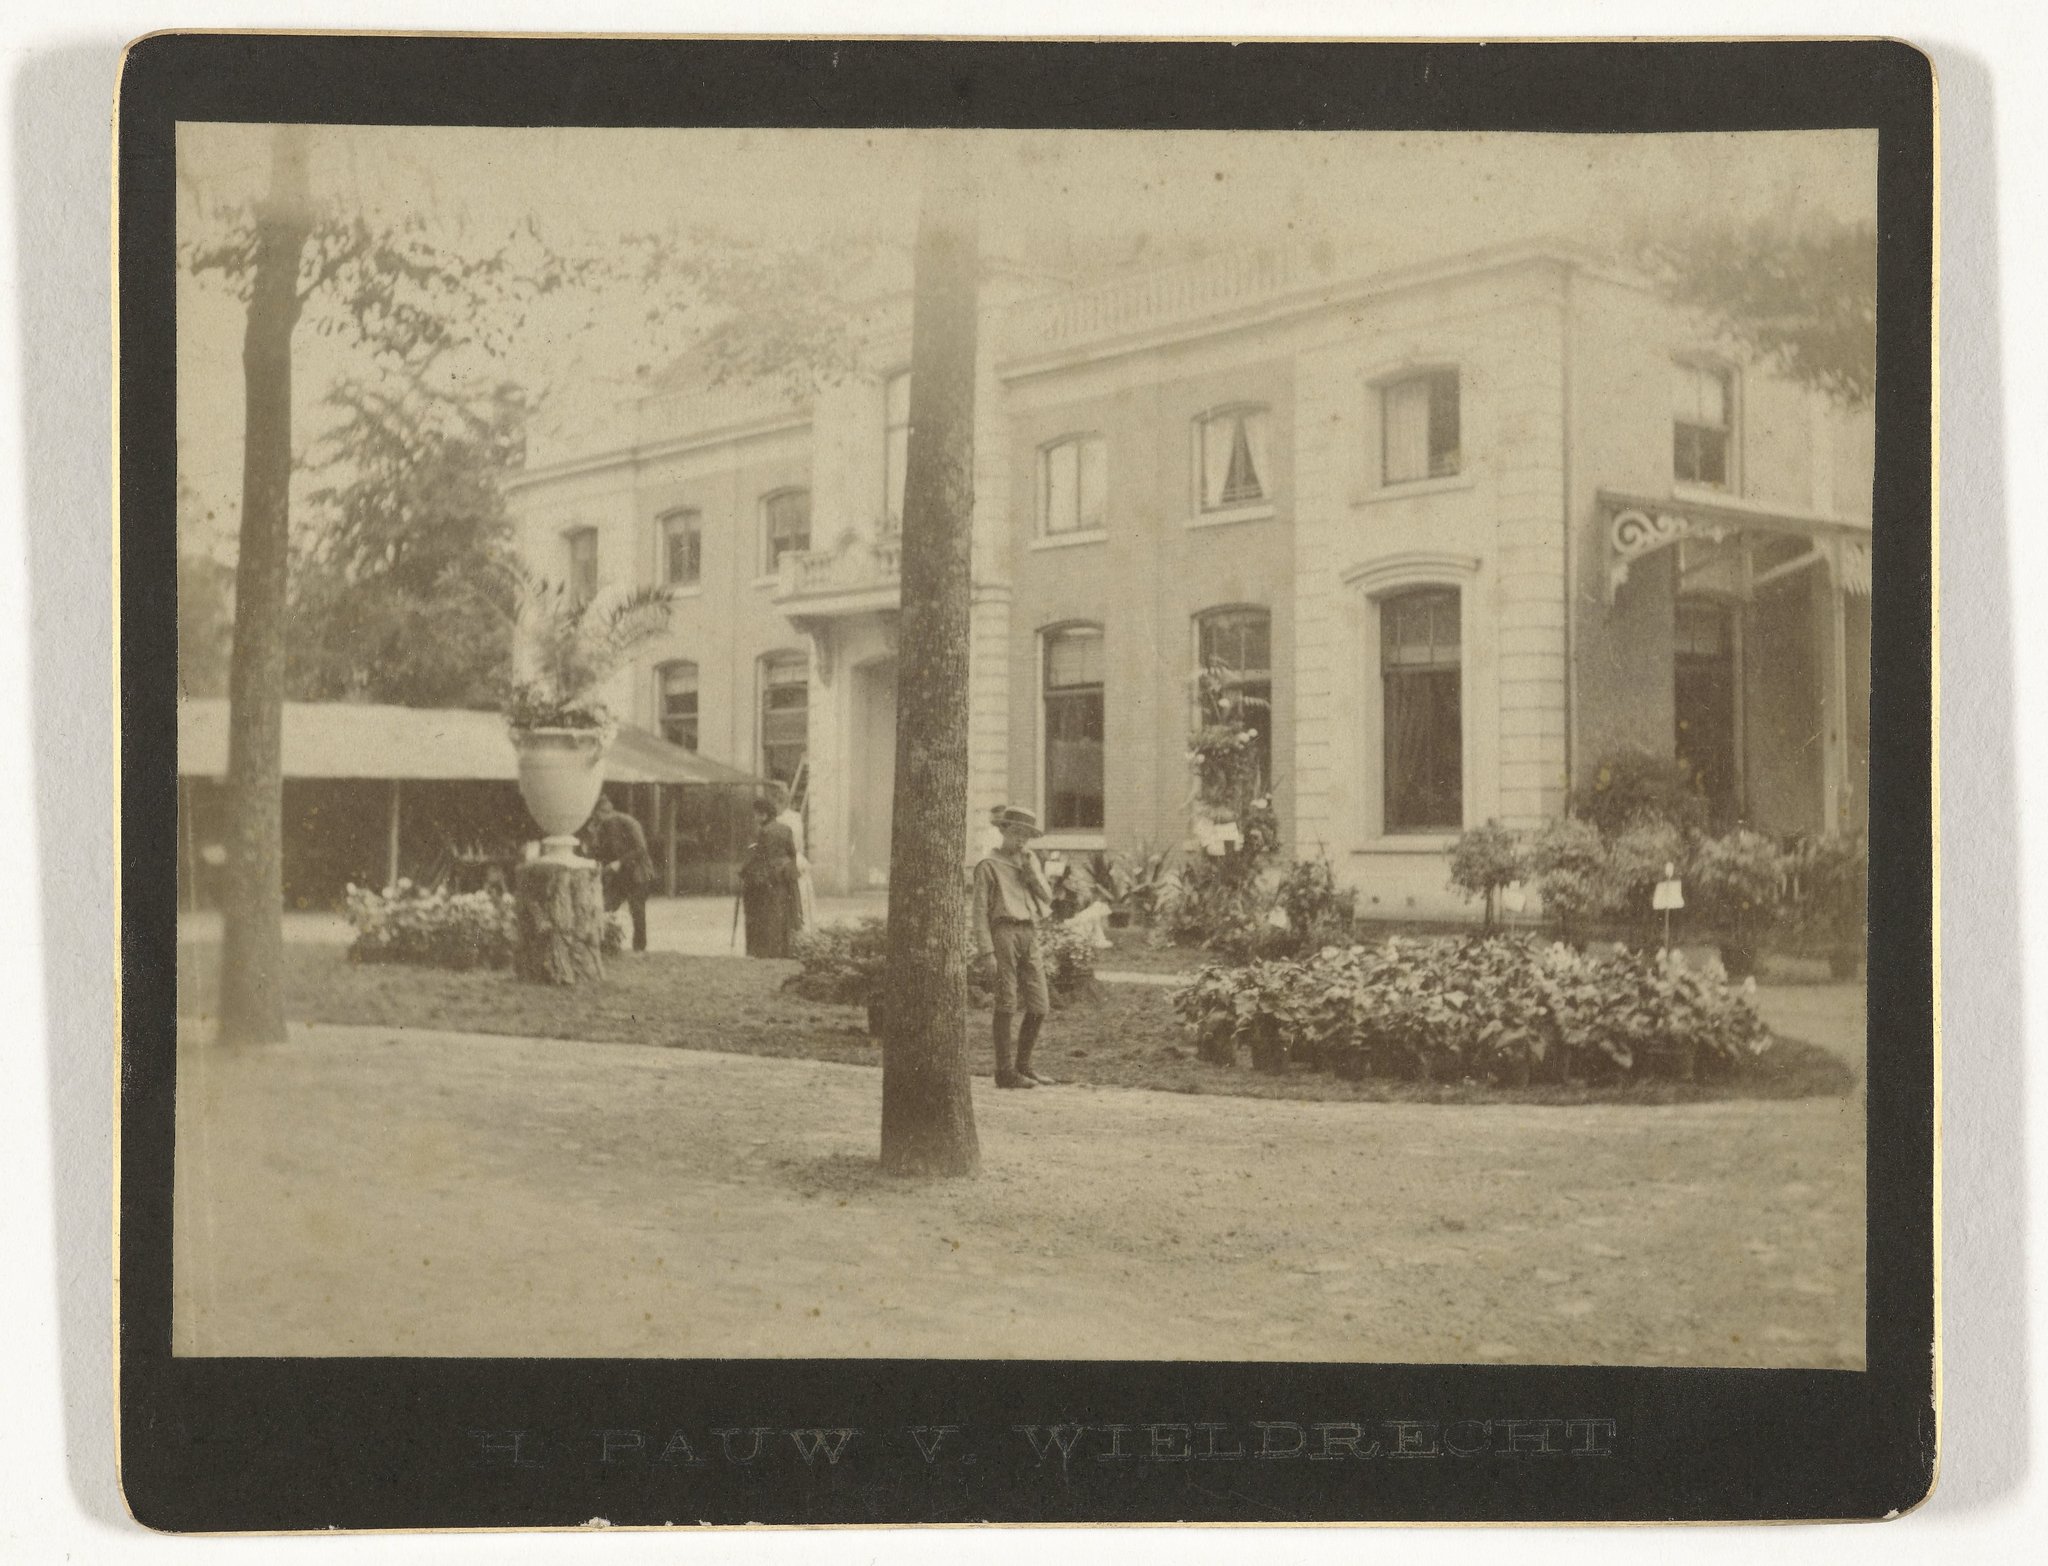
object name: photograph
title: Nieuwe Sociëteit te Zeist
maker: henry pauw van wieldrecht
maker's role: fotograaf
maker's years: 1863-1912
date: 1891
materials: cardboard, photographic support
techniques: albumen print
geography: netherlands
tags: zeist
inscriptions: annotation: ‘No. 63. 408. 1891.’, signature: ‘H. PAUW V. WIELDRECHT’